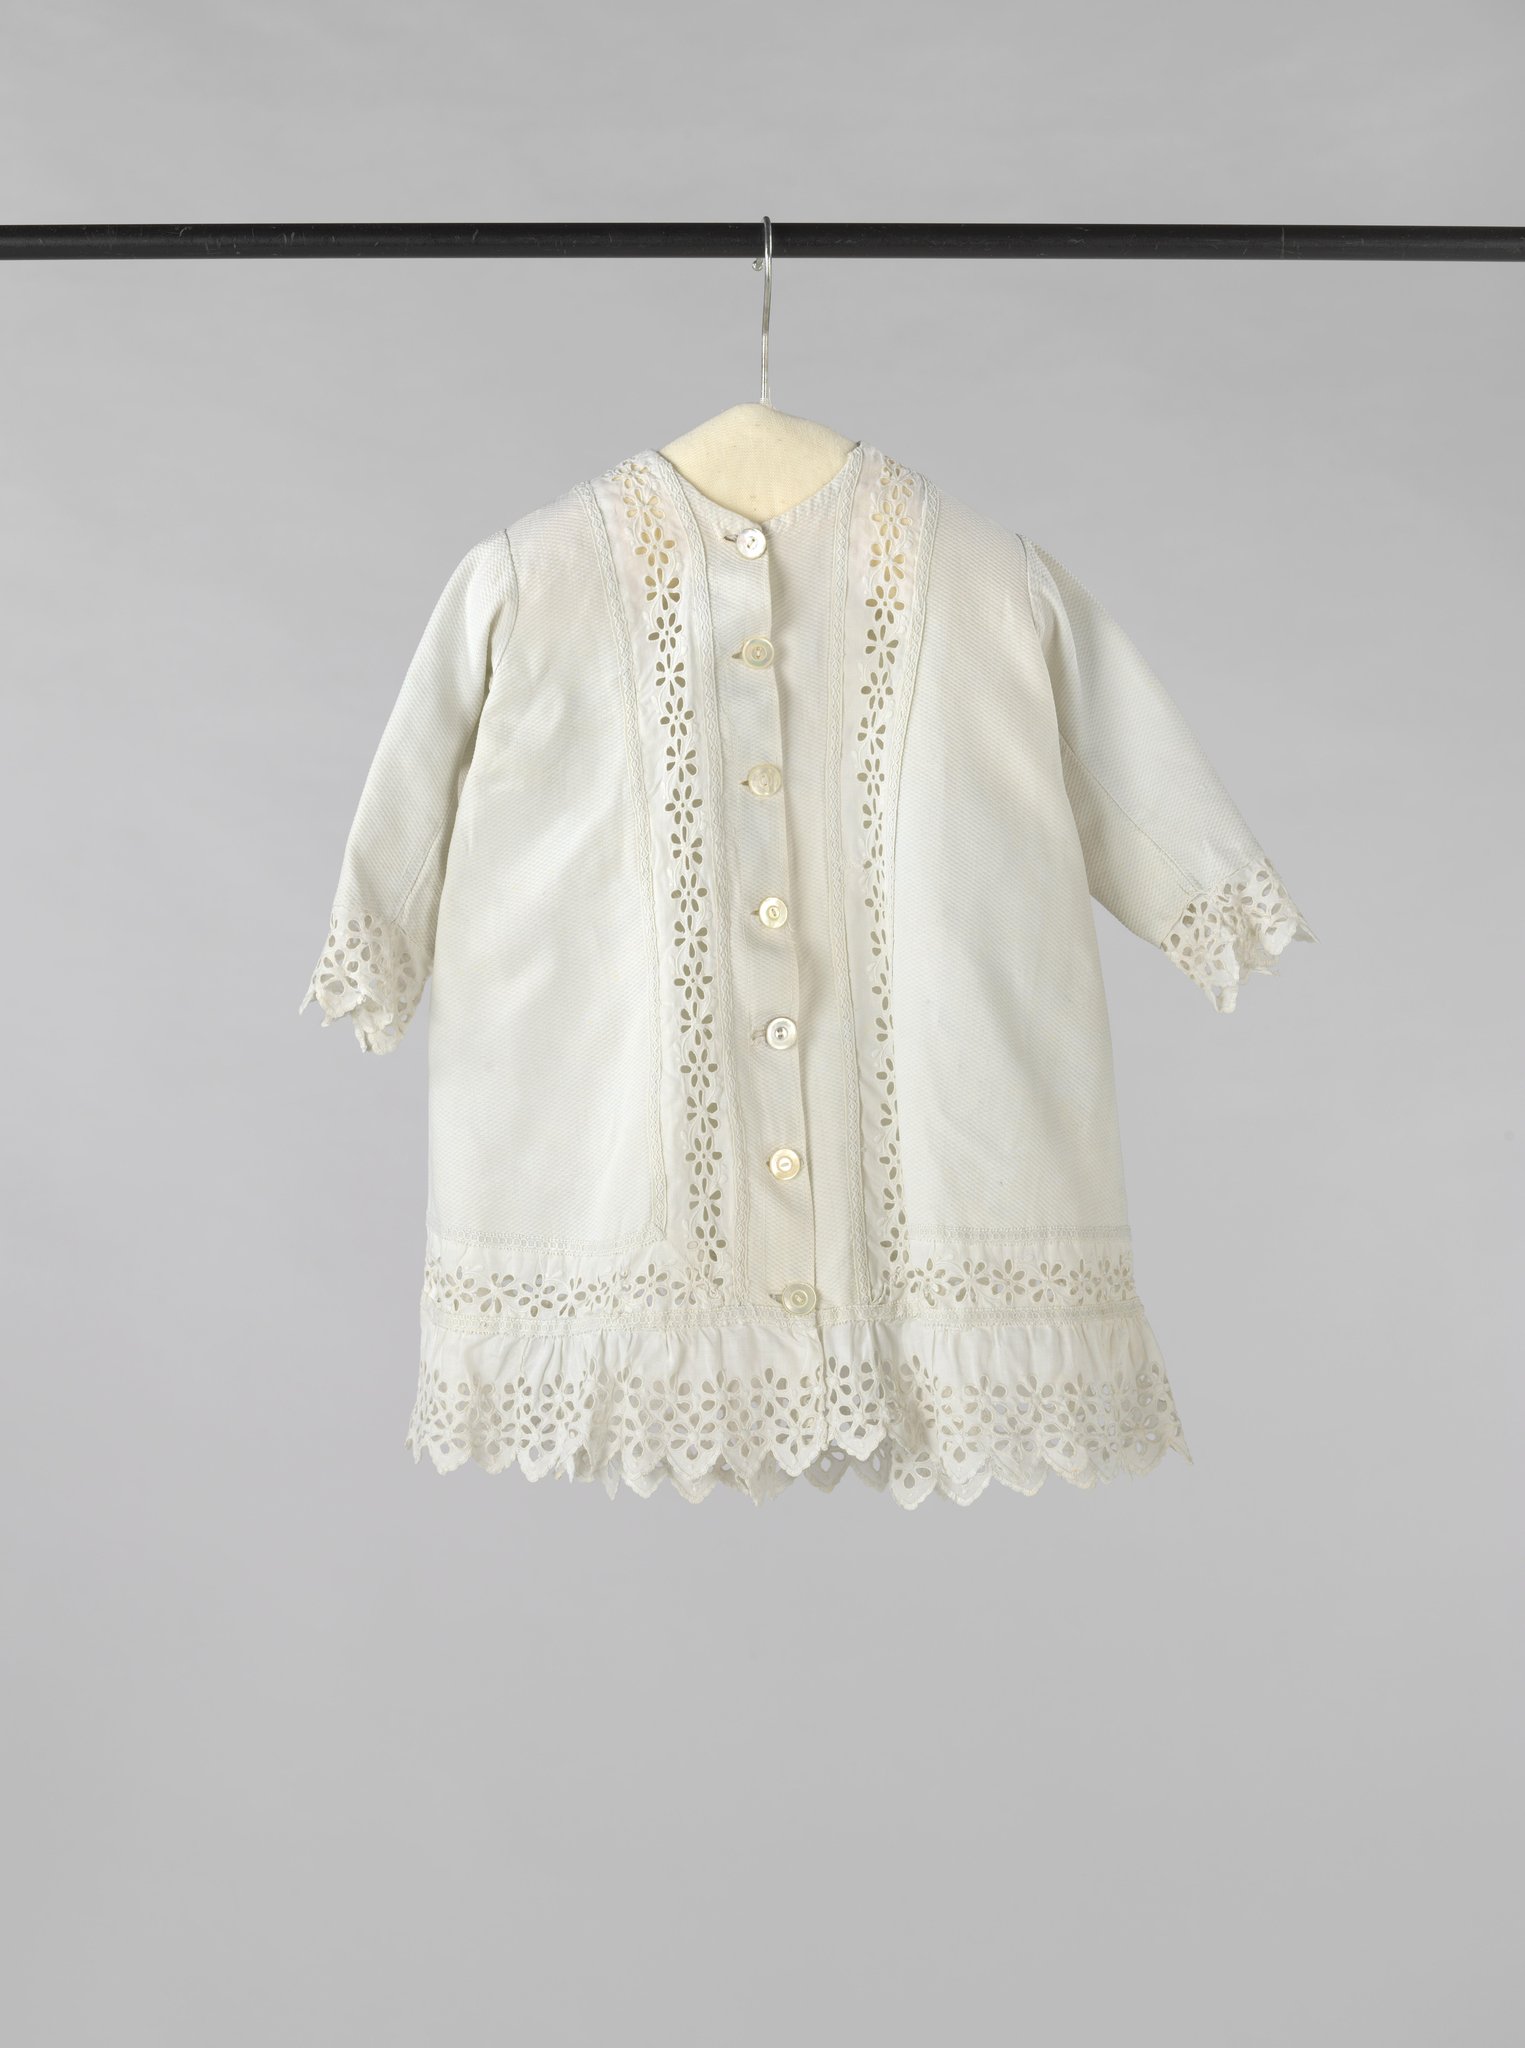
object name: childrenswear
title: Kindermantel met lange mouw en voorsluiting met zeven parelmoeren knopen van wit piqué, versierd met Engels borduurwerk en smal galon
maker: Anonymous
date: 1900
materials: mother of pearl, textile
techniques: embroidered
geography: netherlands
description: Een kindermanteltje van wit piqué en Engels borduurwerk.